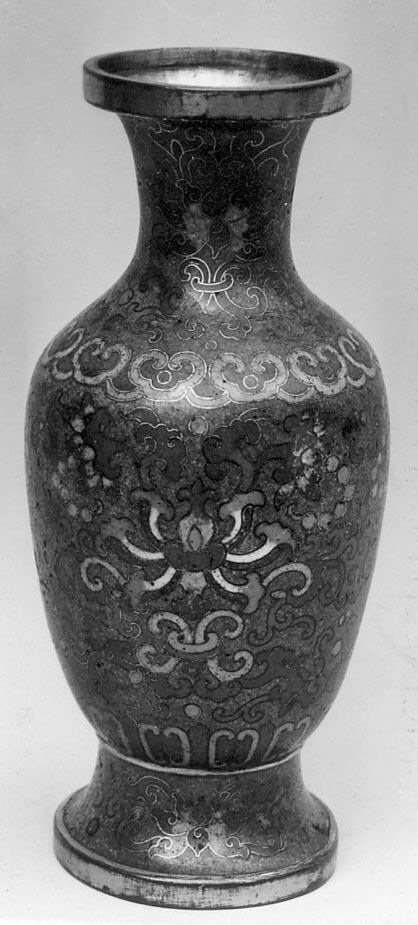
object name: vase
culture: chinese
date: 1736-1795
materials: copper, enamel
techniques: enamel